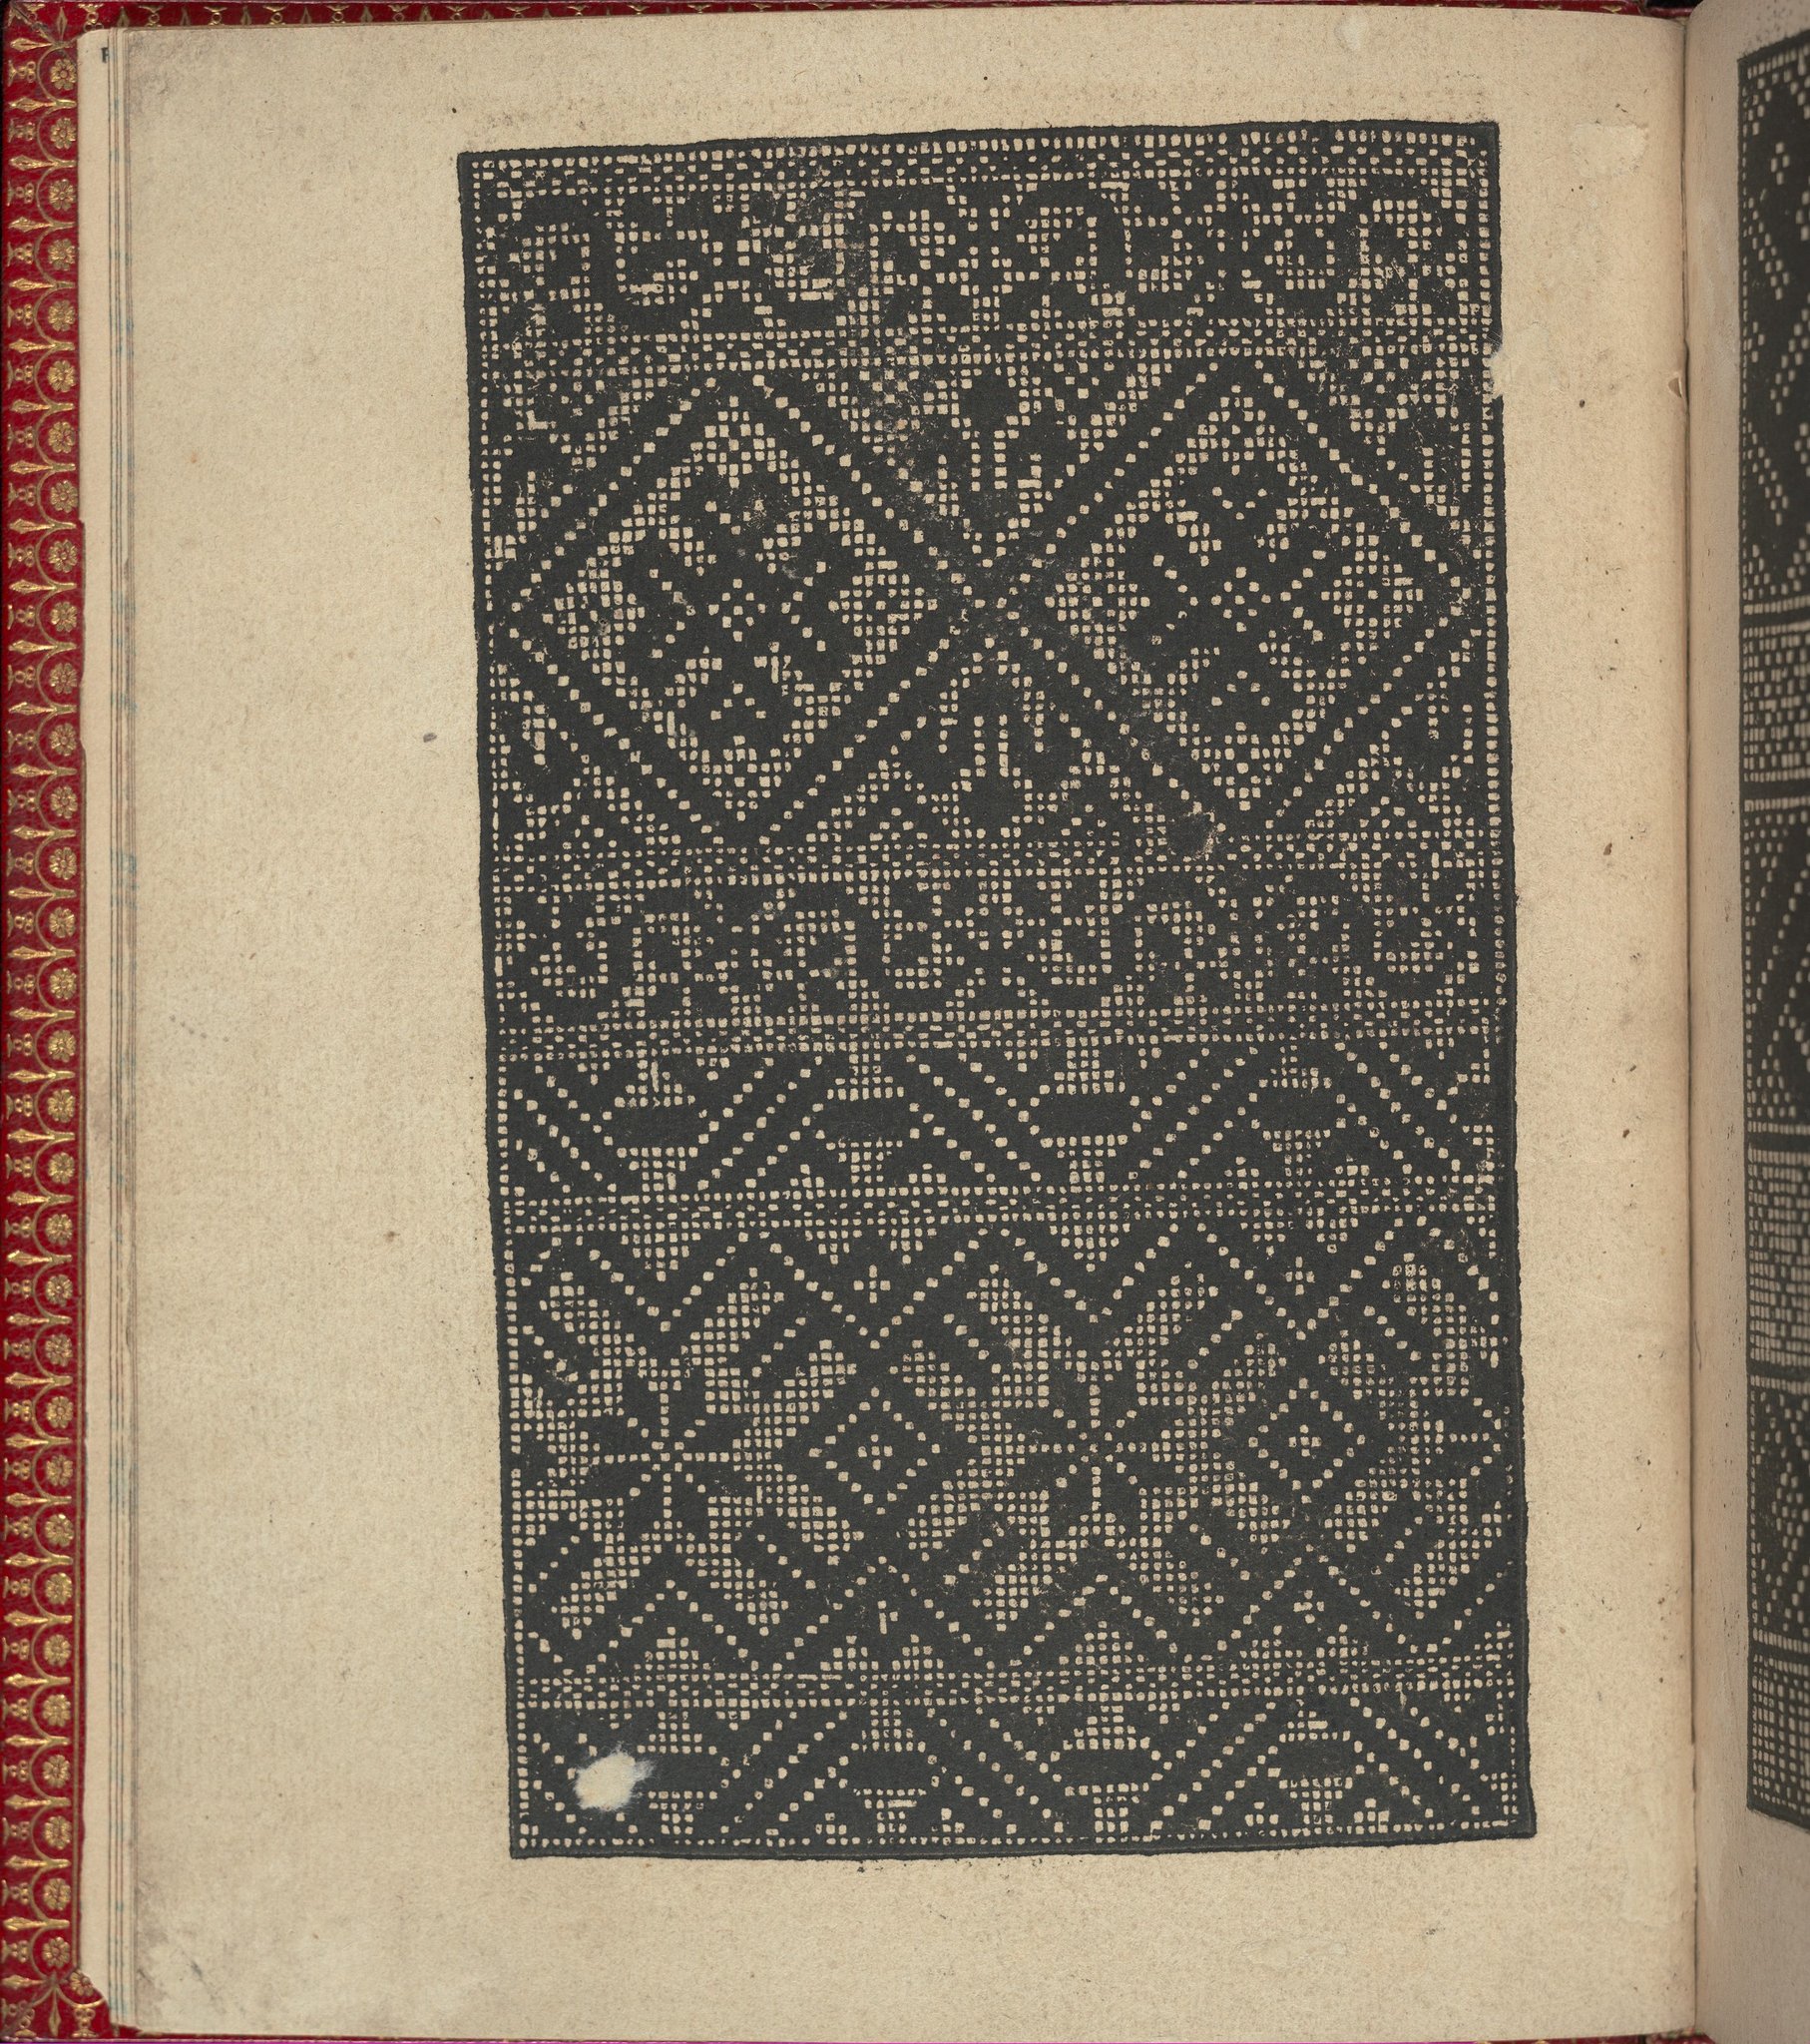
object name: book print ornament architecture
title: Ce est ung tractat de la noble art de leguille ascavoir ouvraiges de spaigne... page 3 (verso)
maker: willem vosterman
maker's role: printer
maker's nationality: netherlandish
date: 1527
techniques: woodcut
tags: flowers